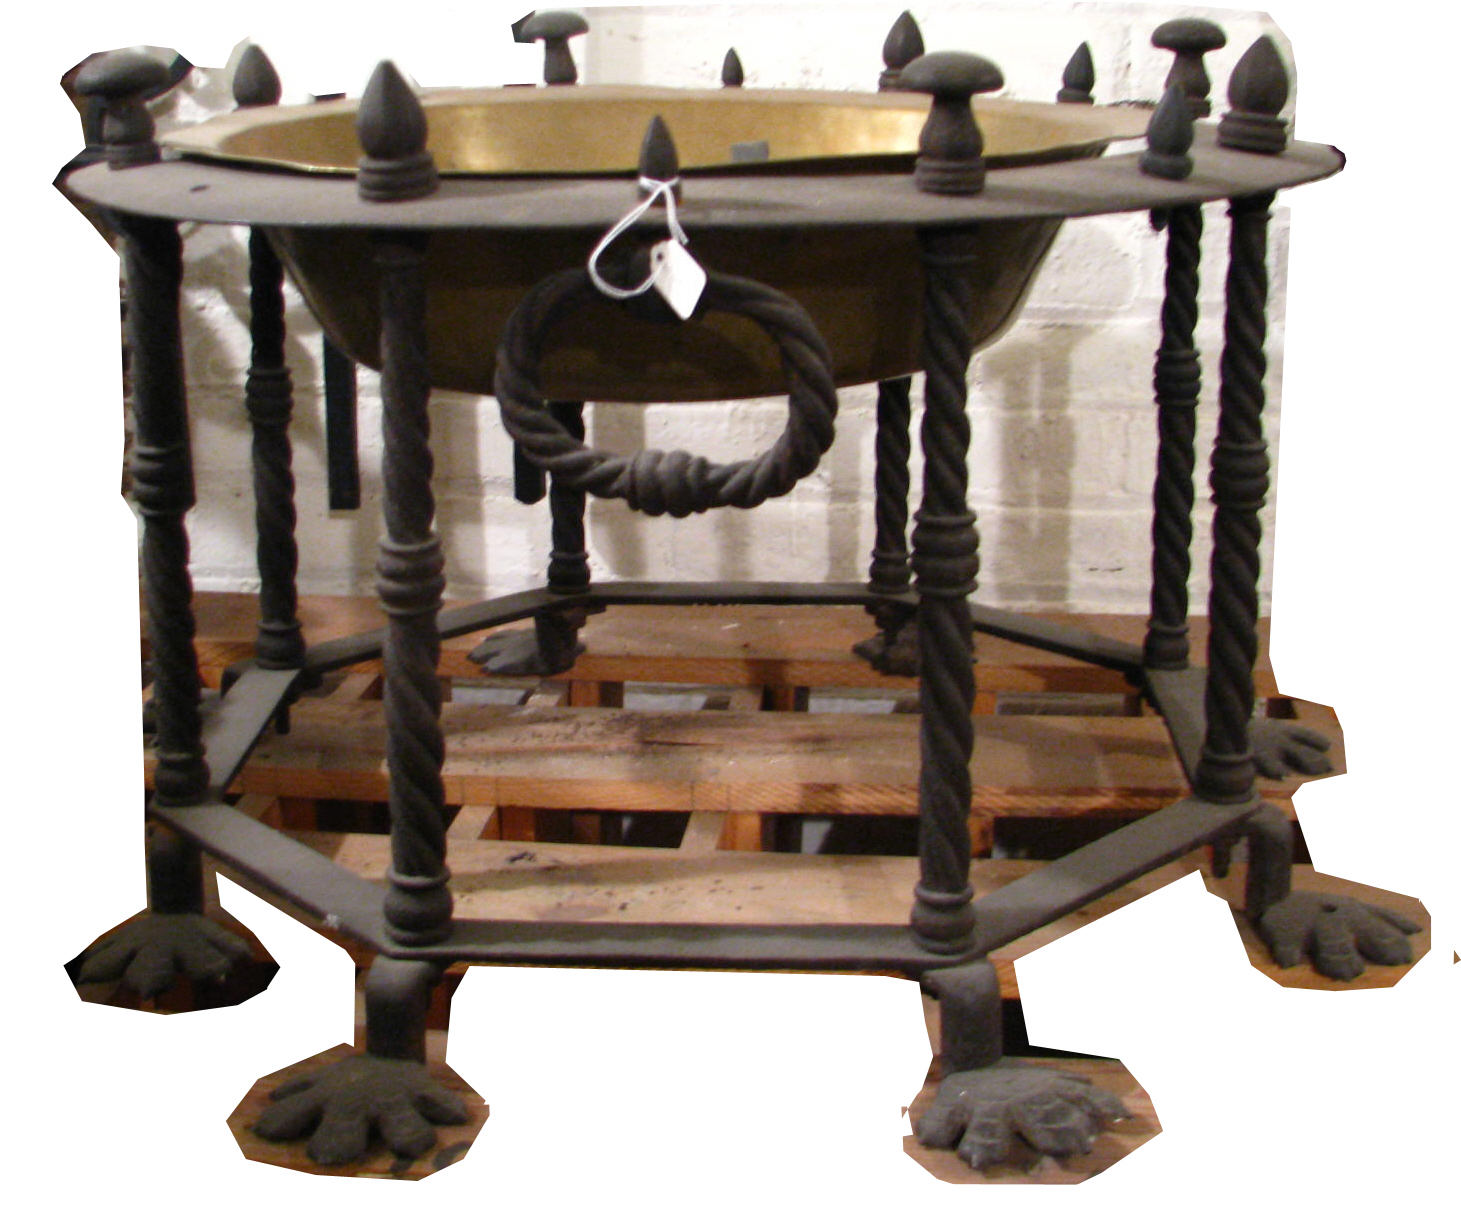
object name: brazier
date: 1467-1533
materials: brass, iron